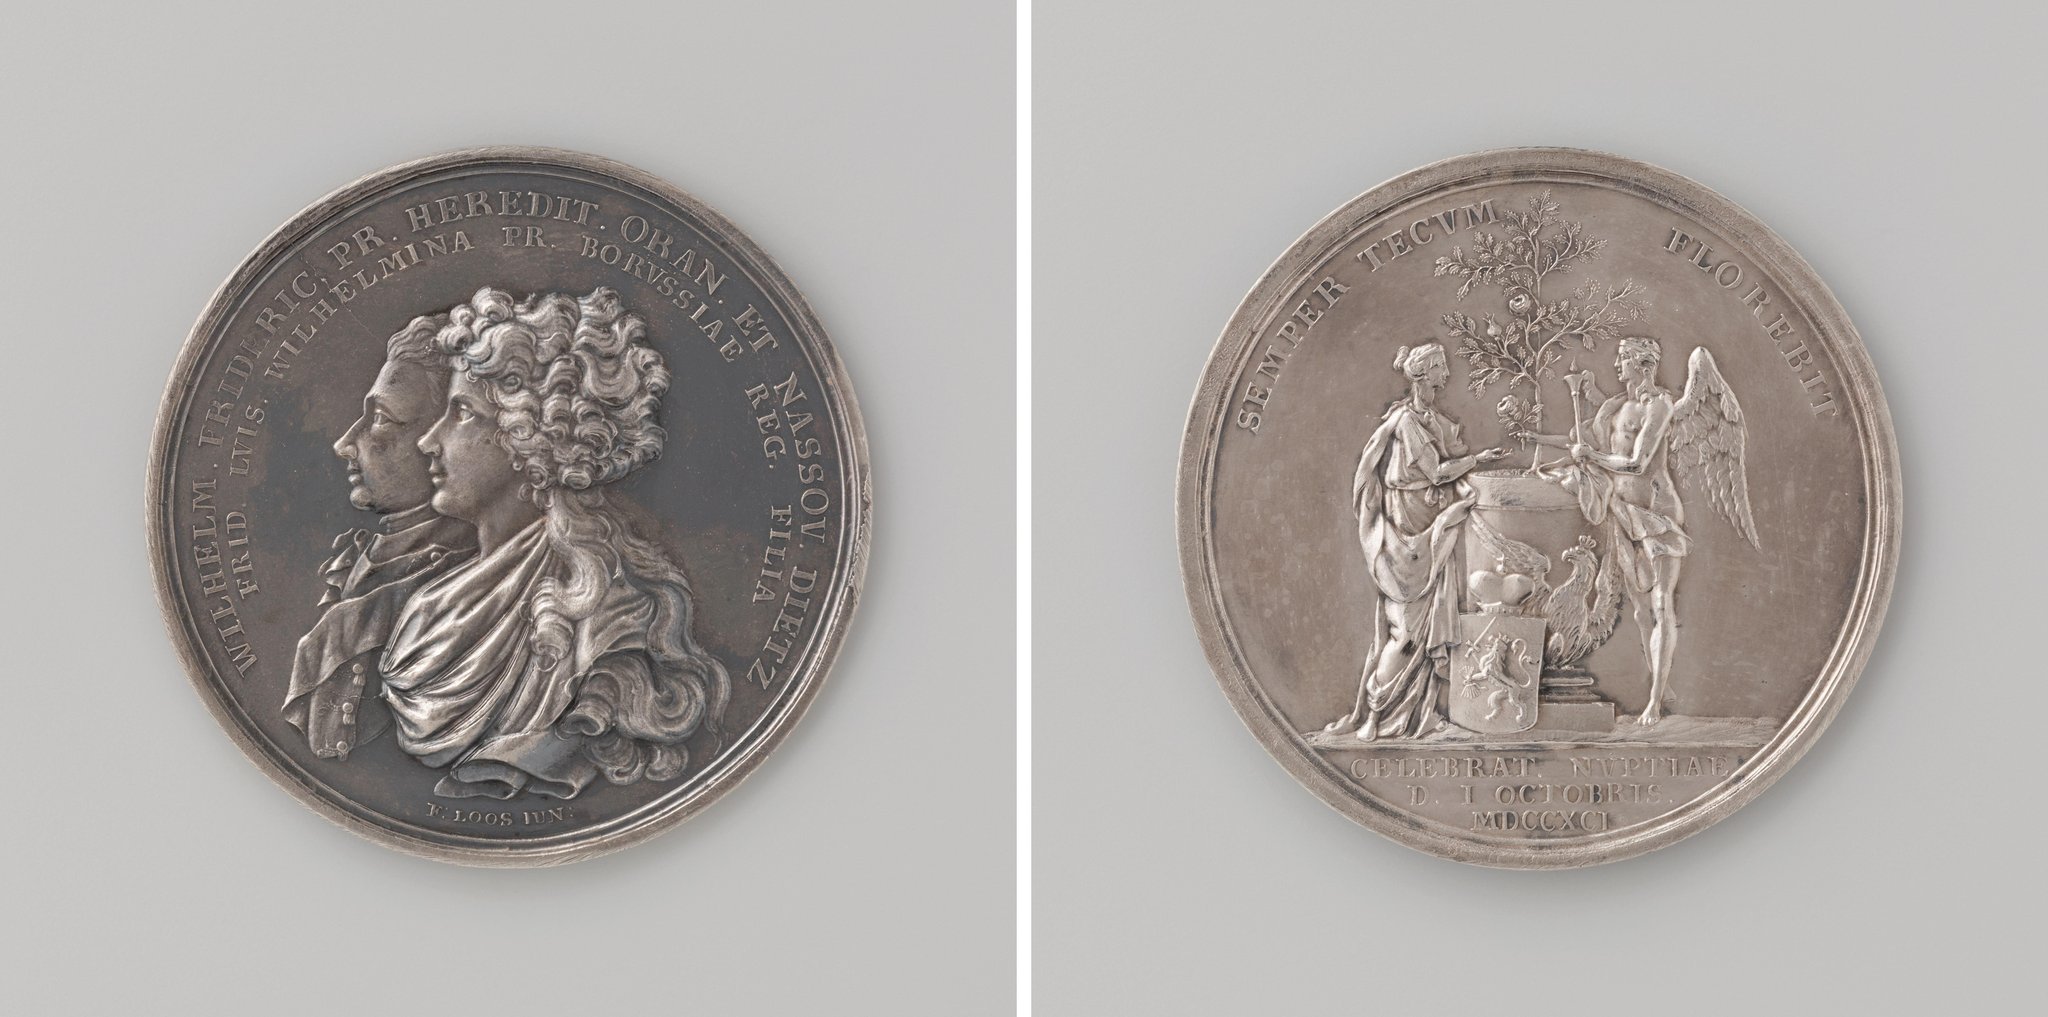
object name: history medal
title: Huwelijk van Willem Frederik, erfprins van Oranje-Nassau en Fredrika Louise Wilhelmina, prinses van Pruisen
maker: johann jakob gottfried stierle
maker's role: medailleur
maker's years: 1764-1806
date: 1791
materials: silver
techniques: striking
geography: berlin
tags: william i of the netherlands, berlin, wilhelmina frederica louisa (koningin der nederlanden)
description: Zilveren penning. Voorzijde: borststuk man en vrouw binnen tweeregelig omschrift. Keerzijde: twee vrouwen plengen wijn boven brandend altaar, waartegen twee gekroonde, met kransen verenigde wapenschilden staan binnen omschrift; afsnede: opschrift